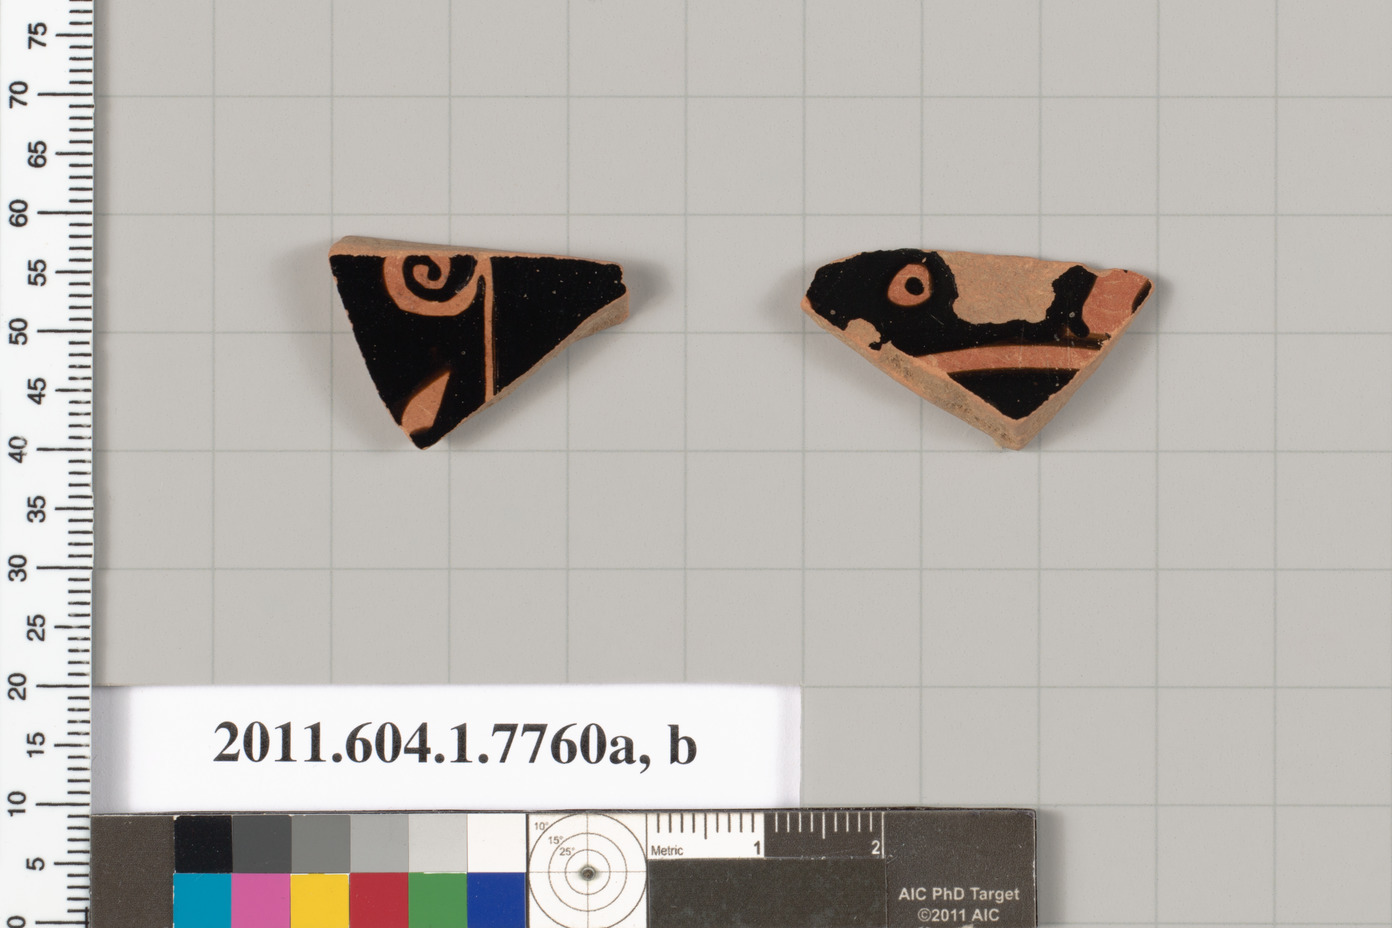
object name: kylix fragment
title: Terracotta fragments of kylikes (drinking cups)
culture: greek, attic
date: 460-450 BCE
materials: terracotta